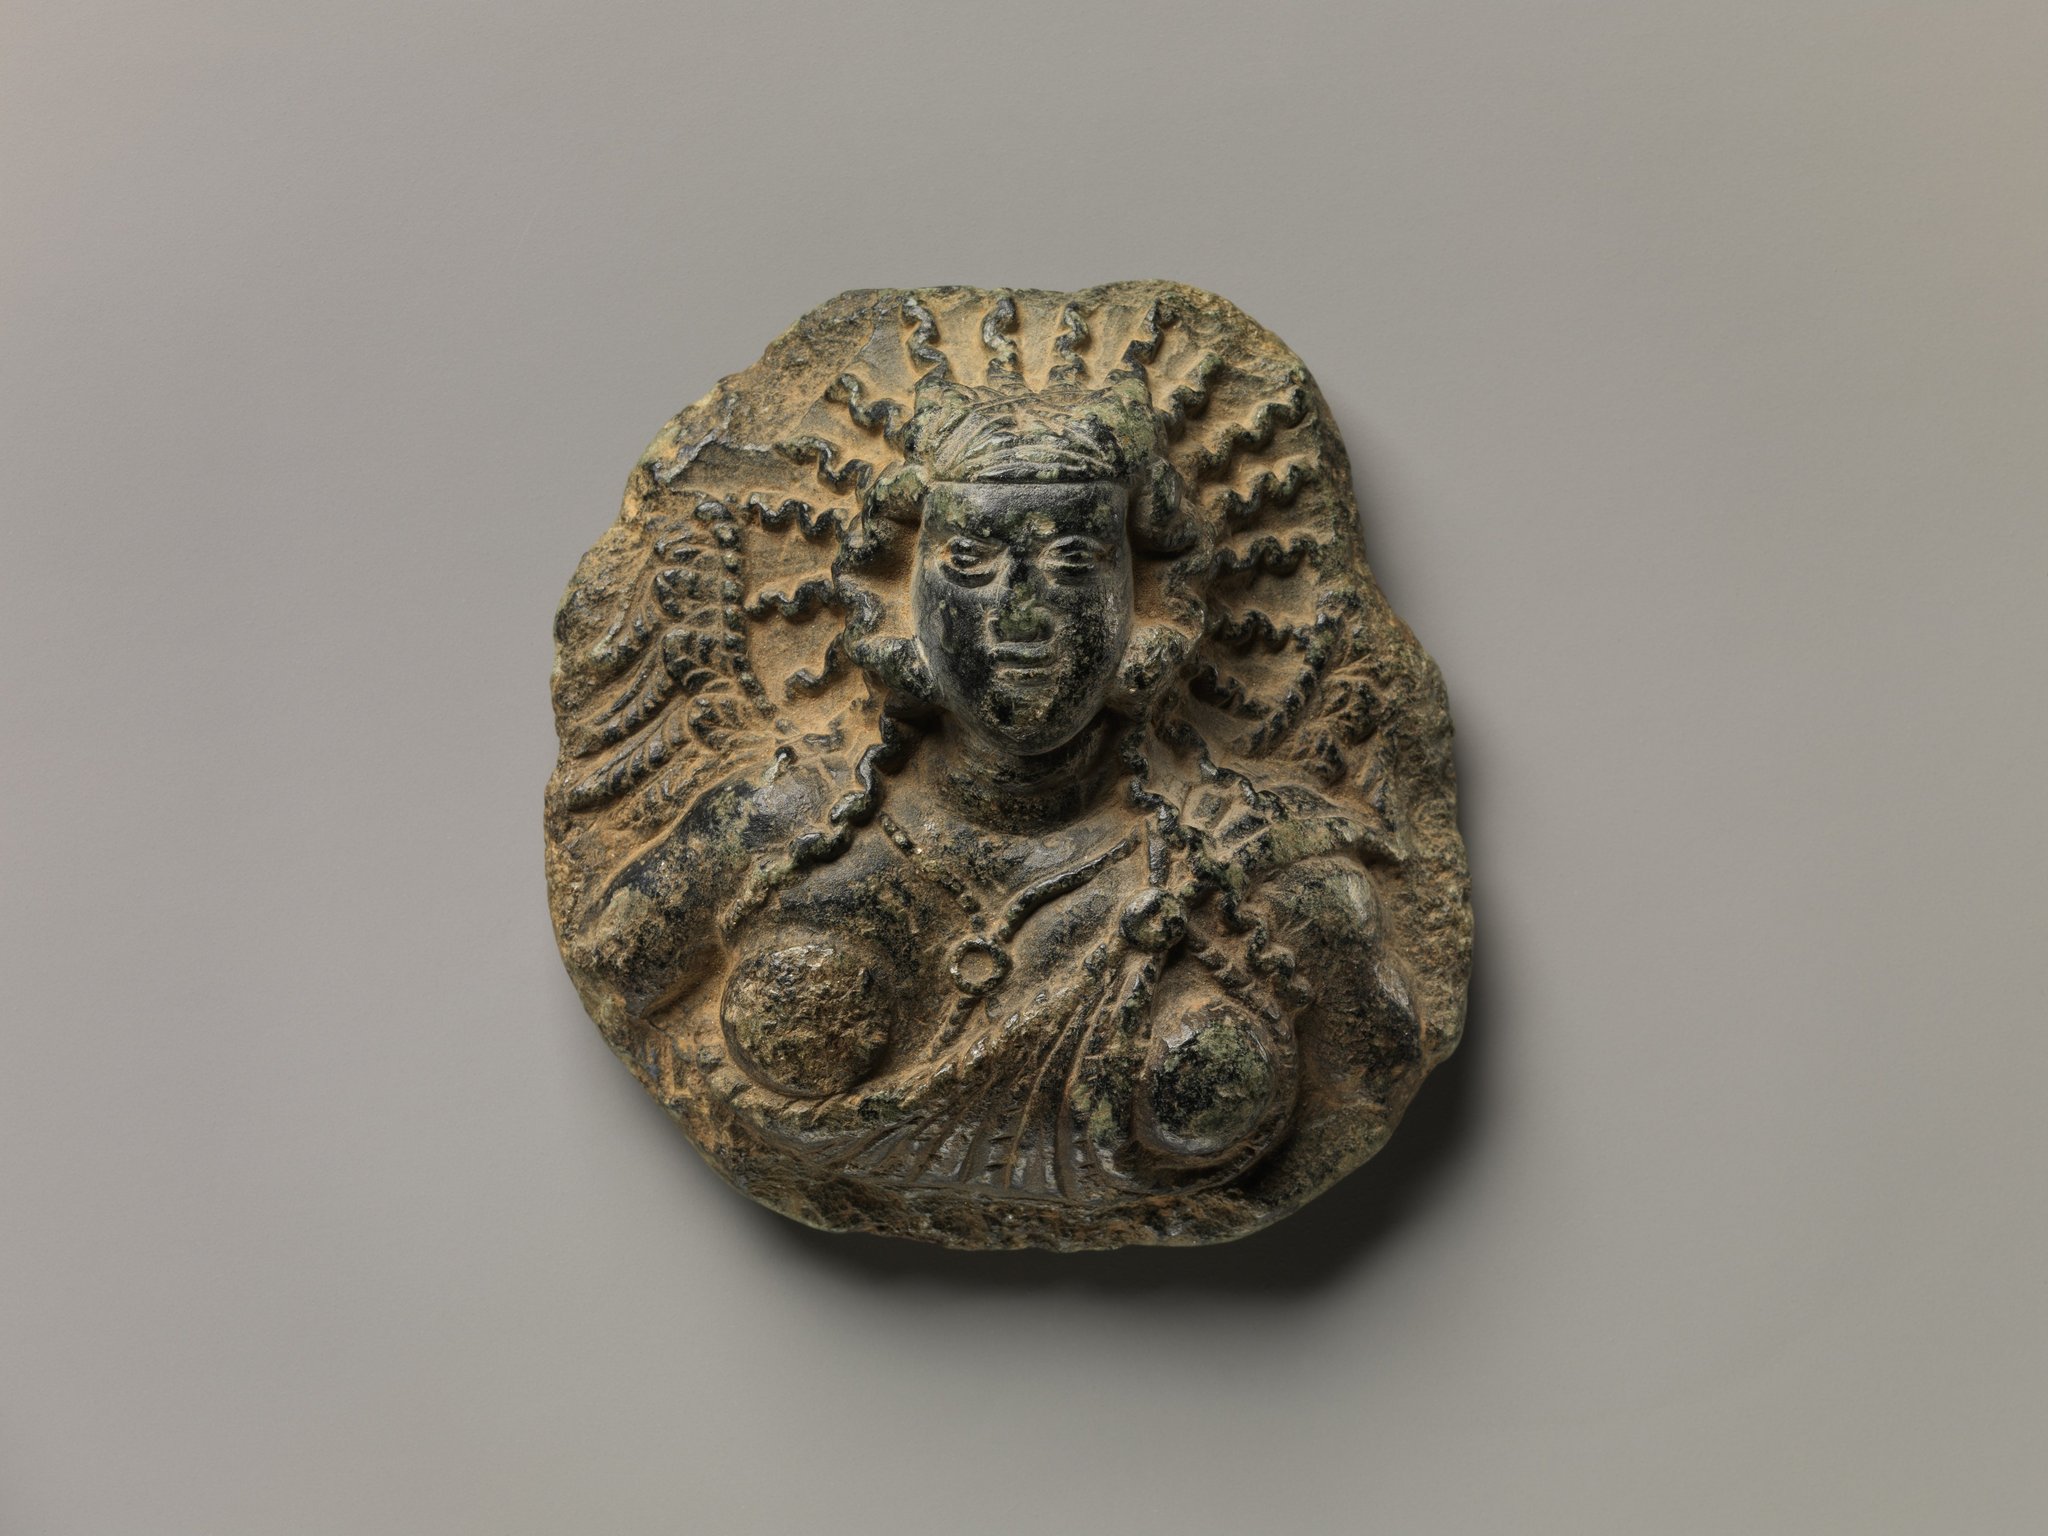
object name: roundel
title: Roundel with a Winged Female Deity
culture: gandhara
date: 1-200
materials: stone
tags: gandhara